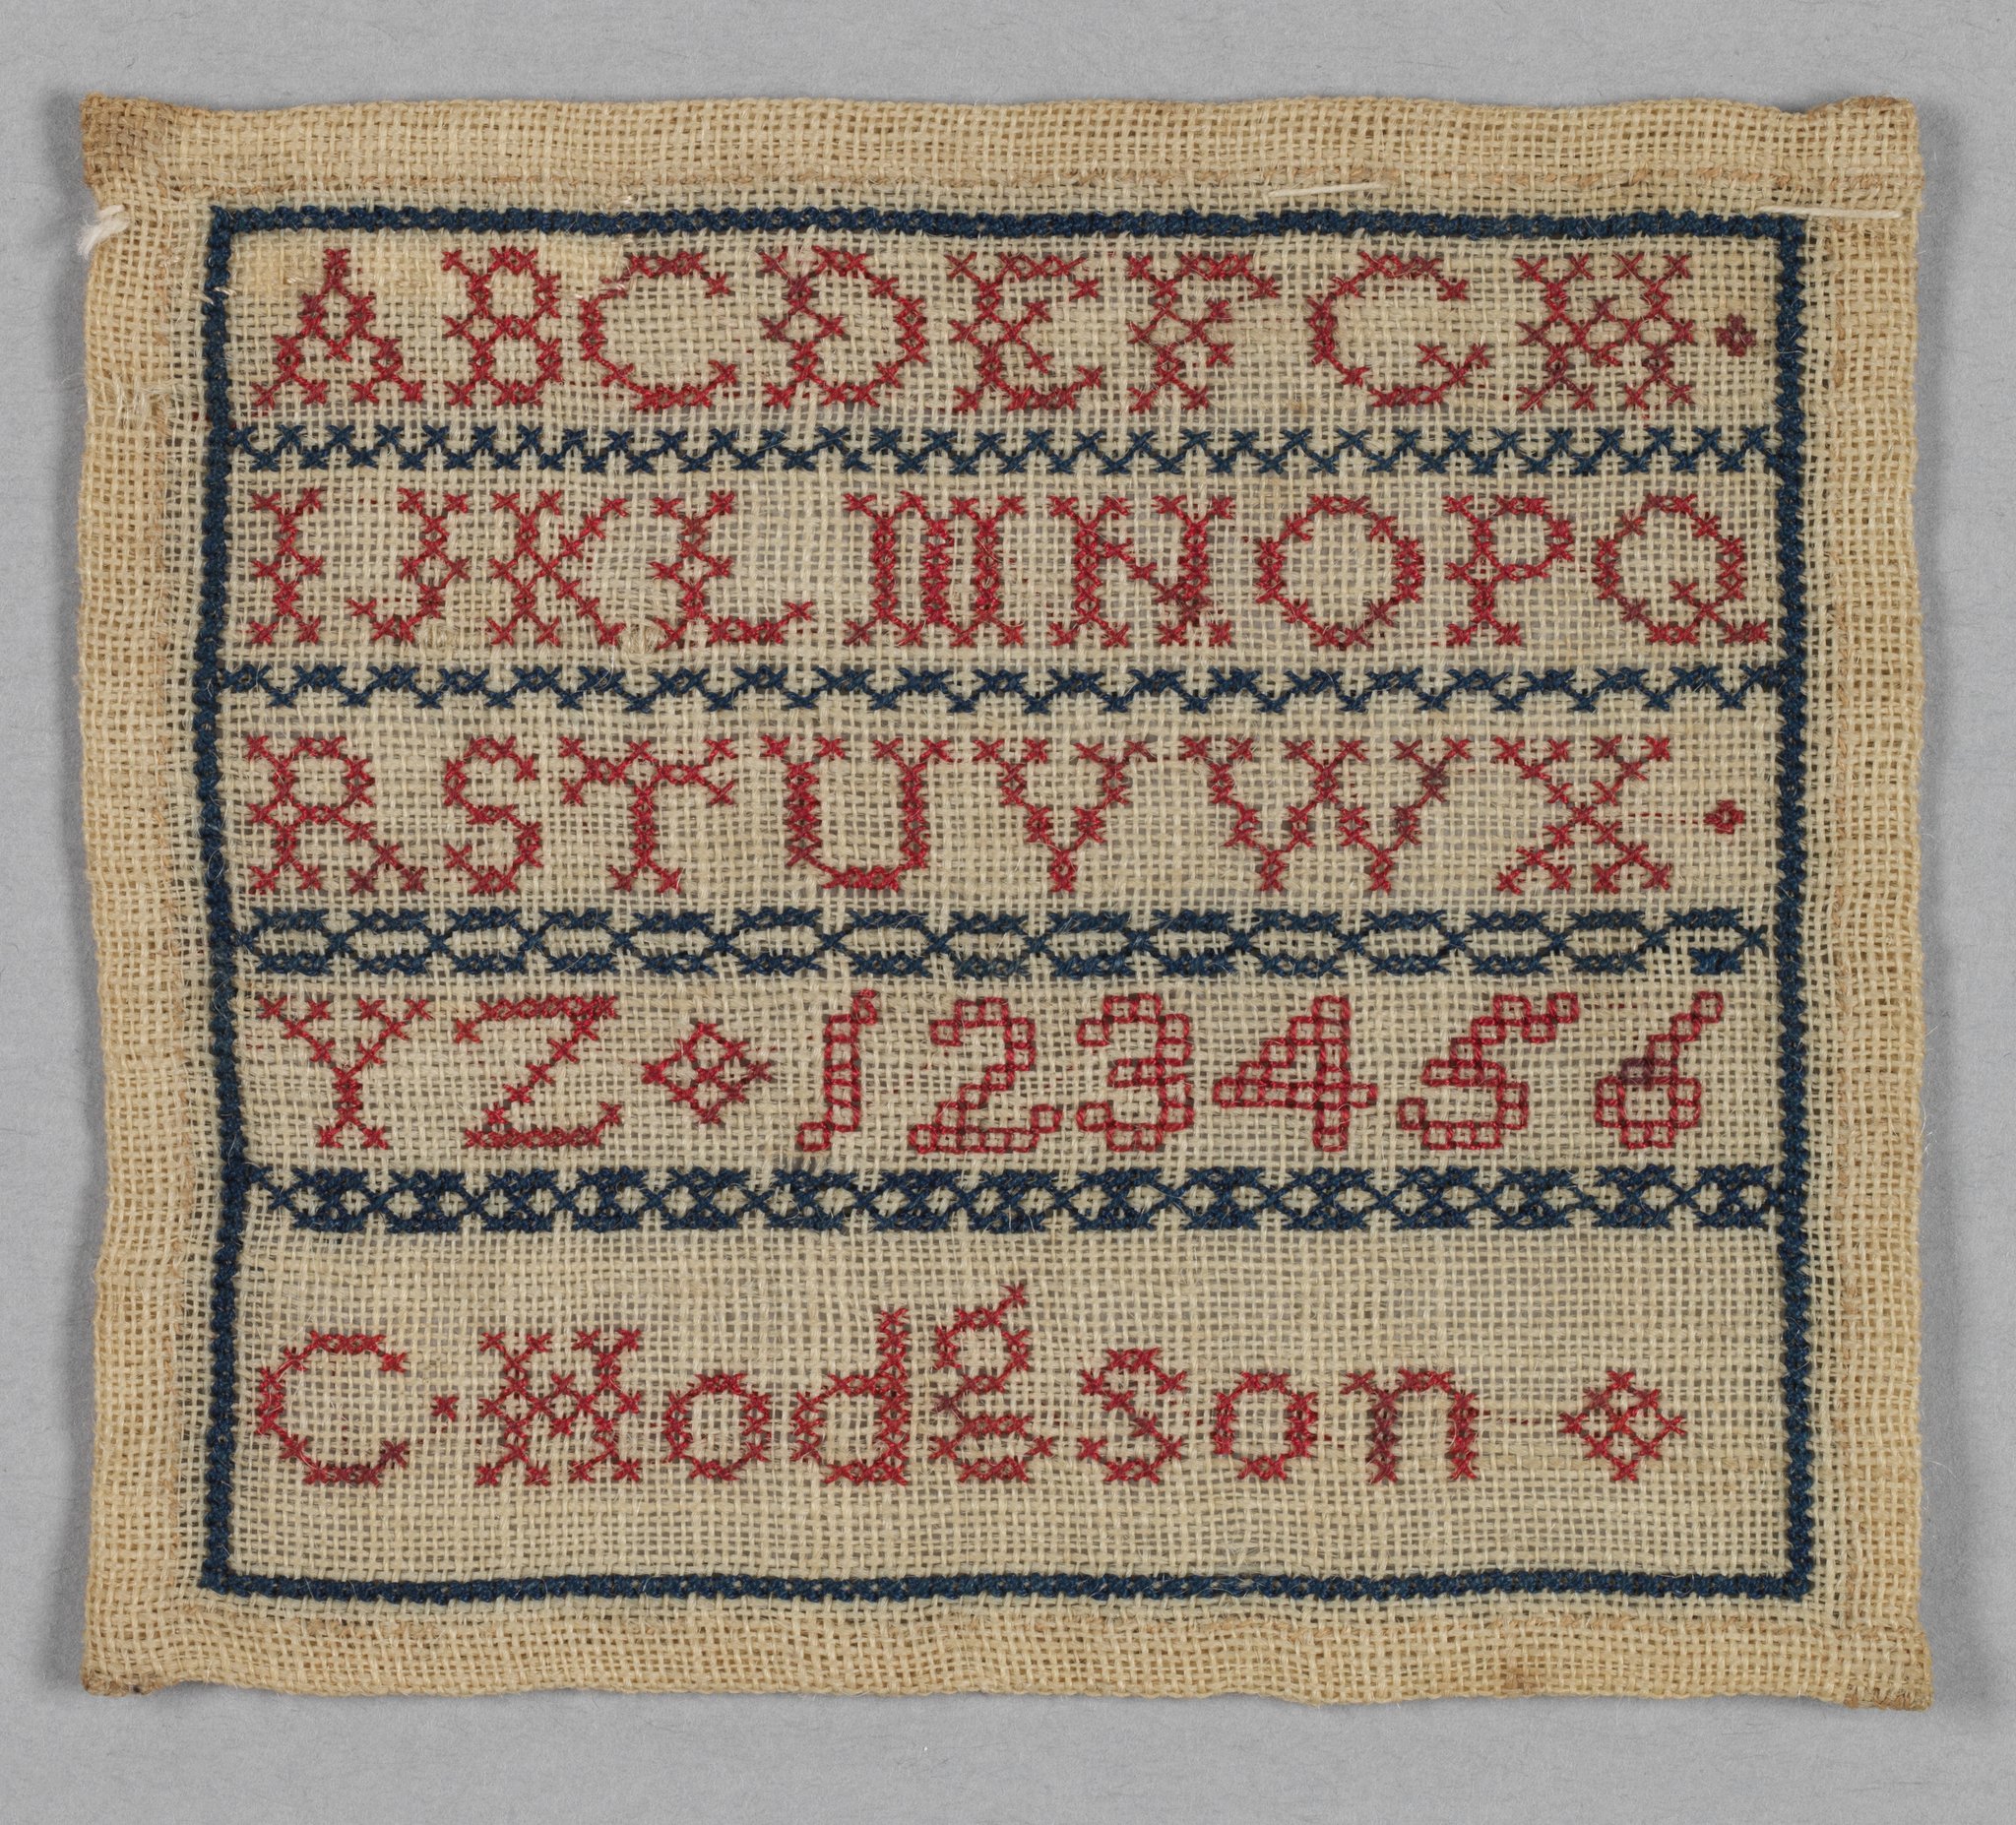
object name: sampler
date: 1801-1900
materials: canvas, silk, wool